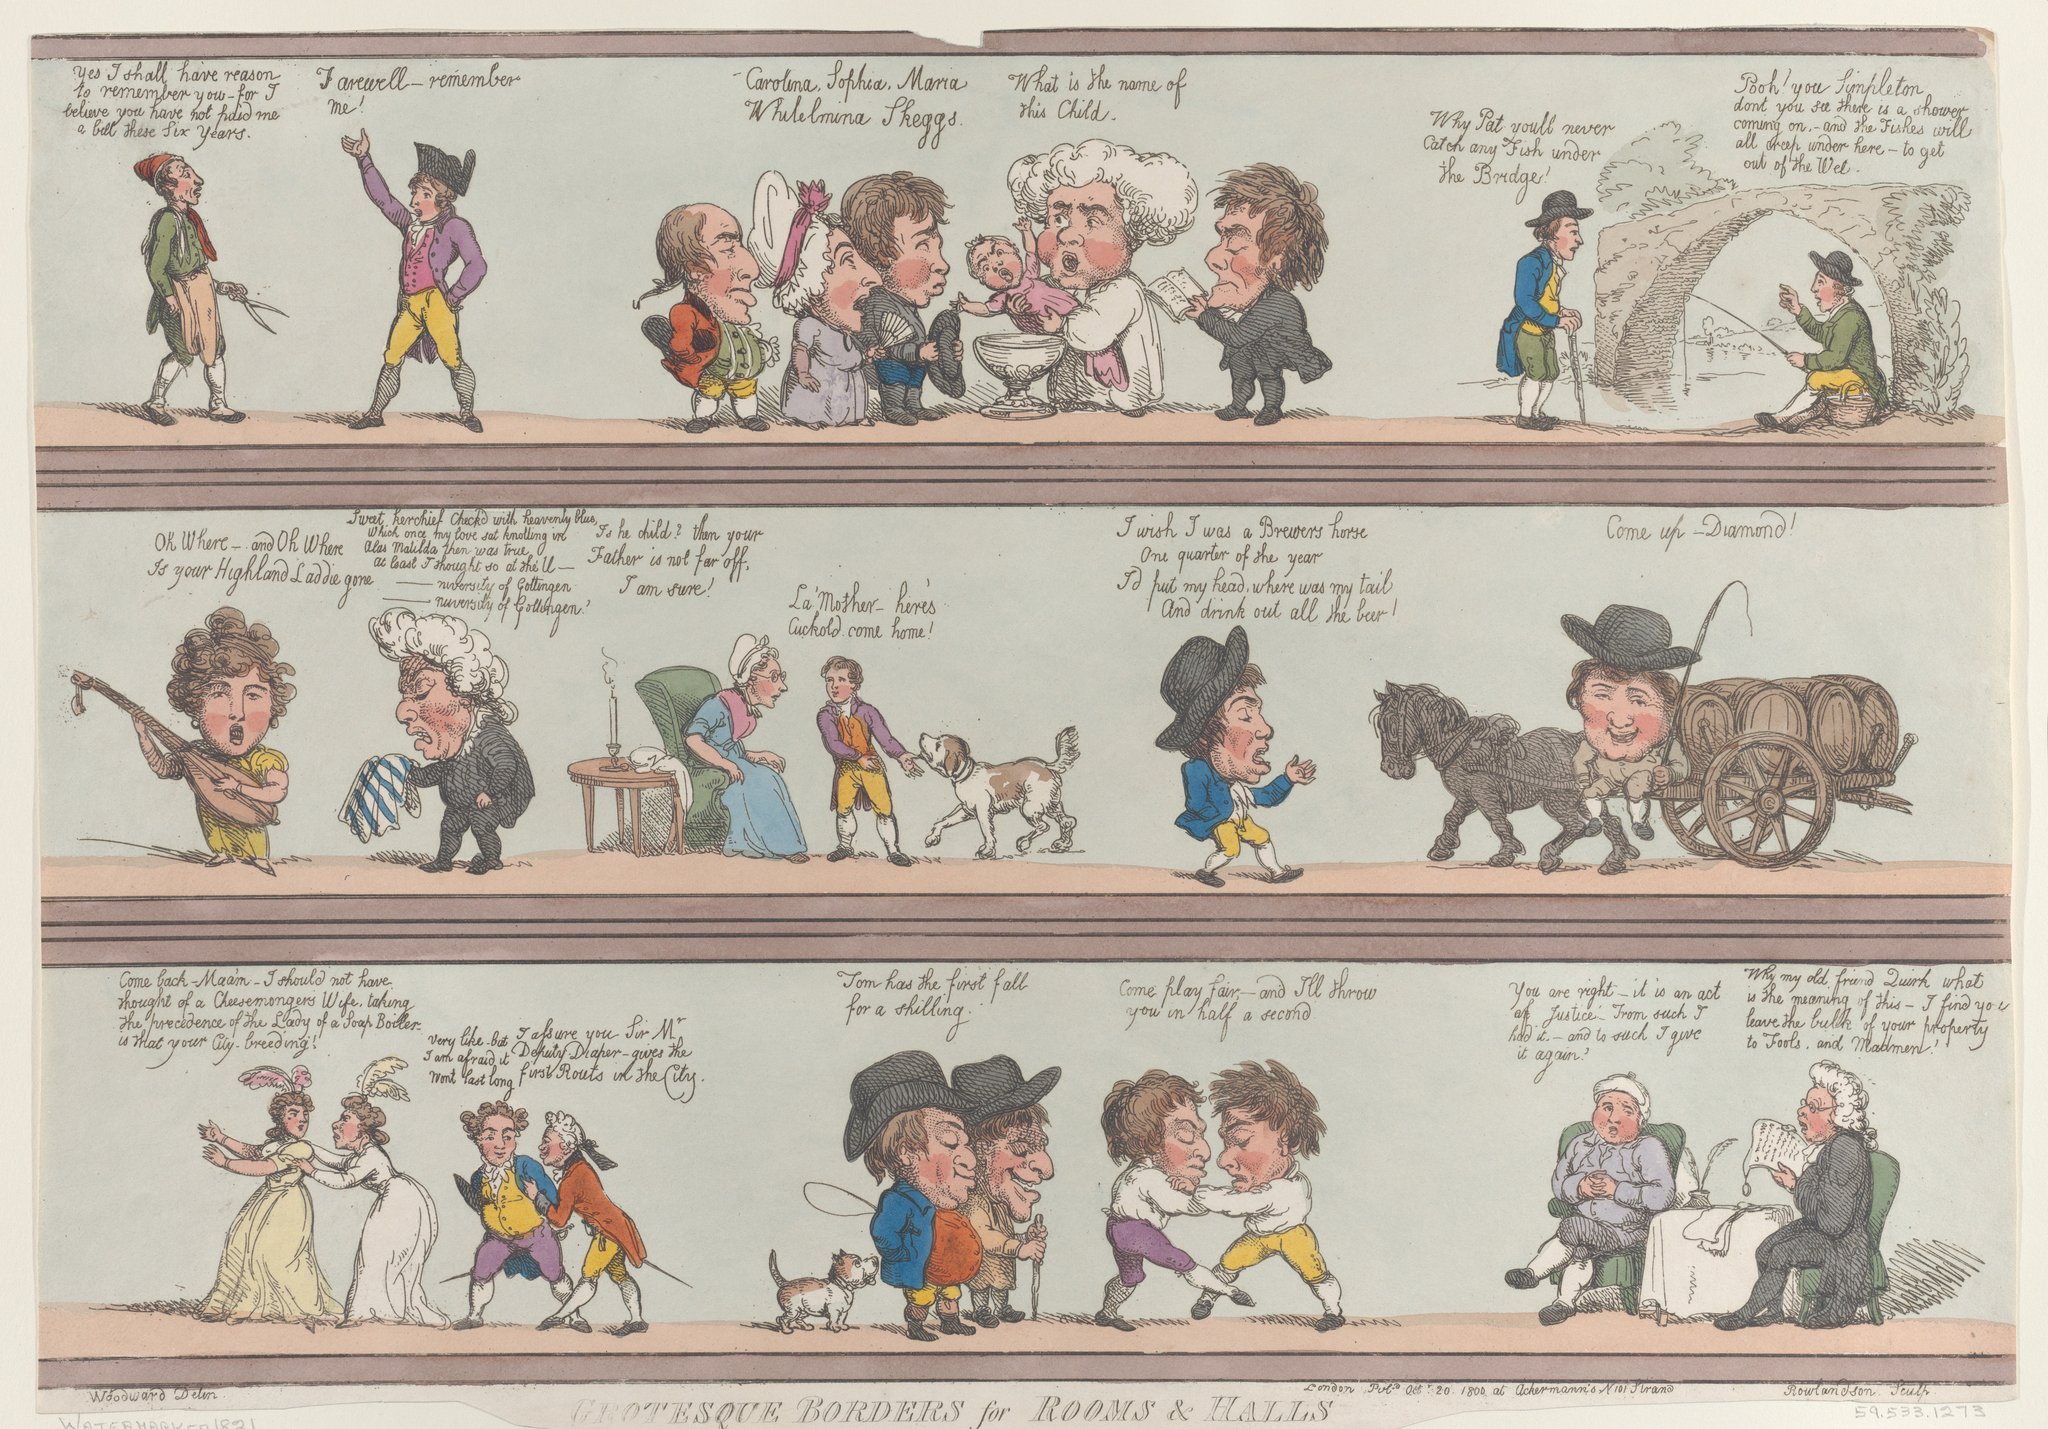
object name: print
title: Grotesque Borders for Rooms & Halls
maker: thomas rowlandson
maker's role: artist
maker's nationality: british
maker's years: 1757-1827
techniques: etching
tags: satire,men,women,dogs,carts